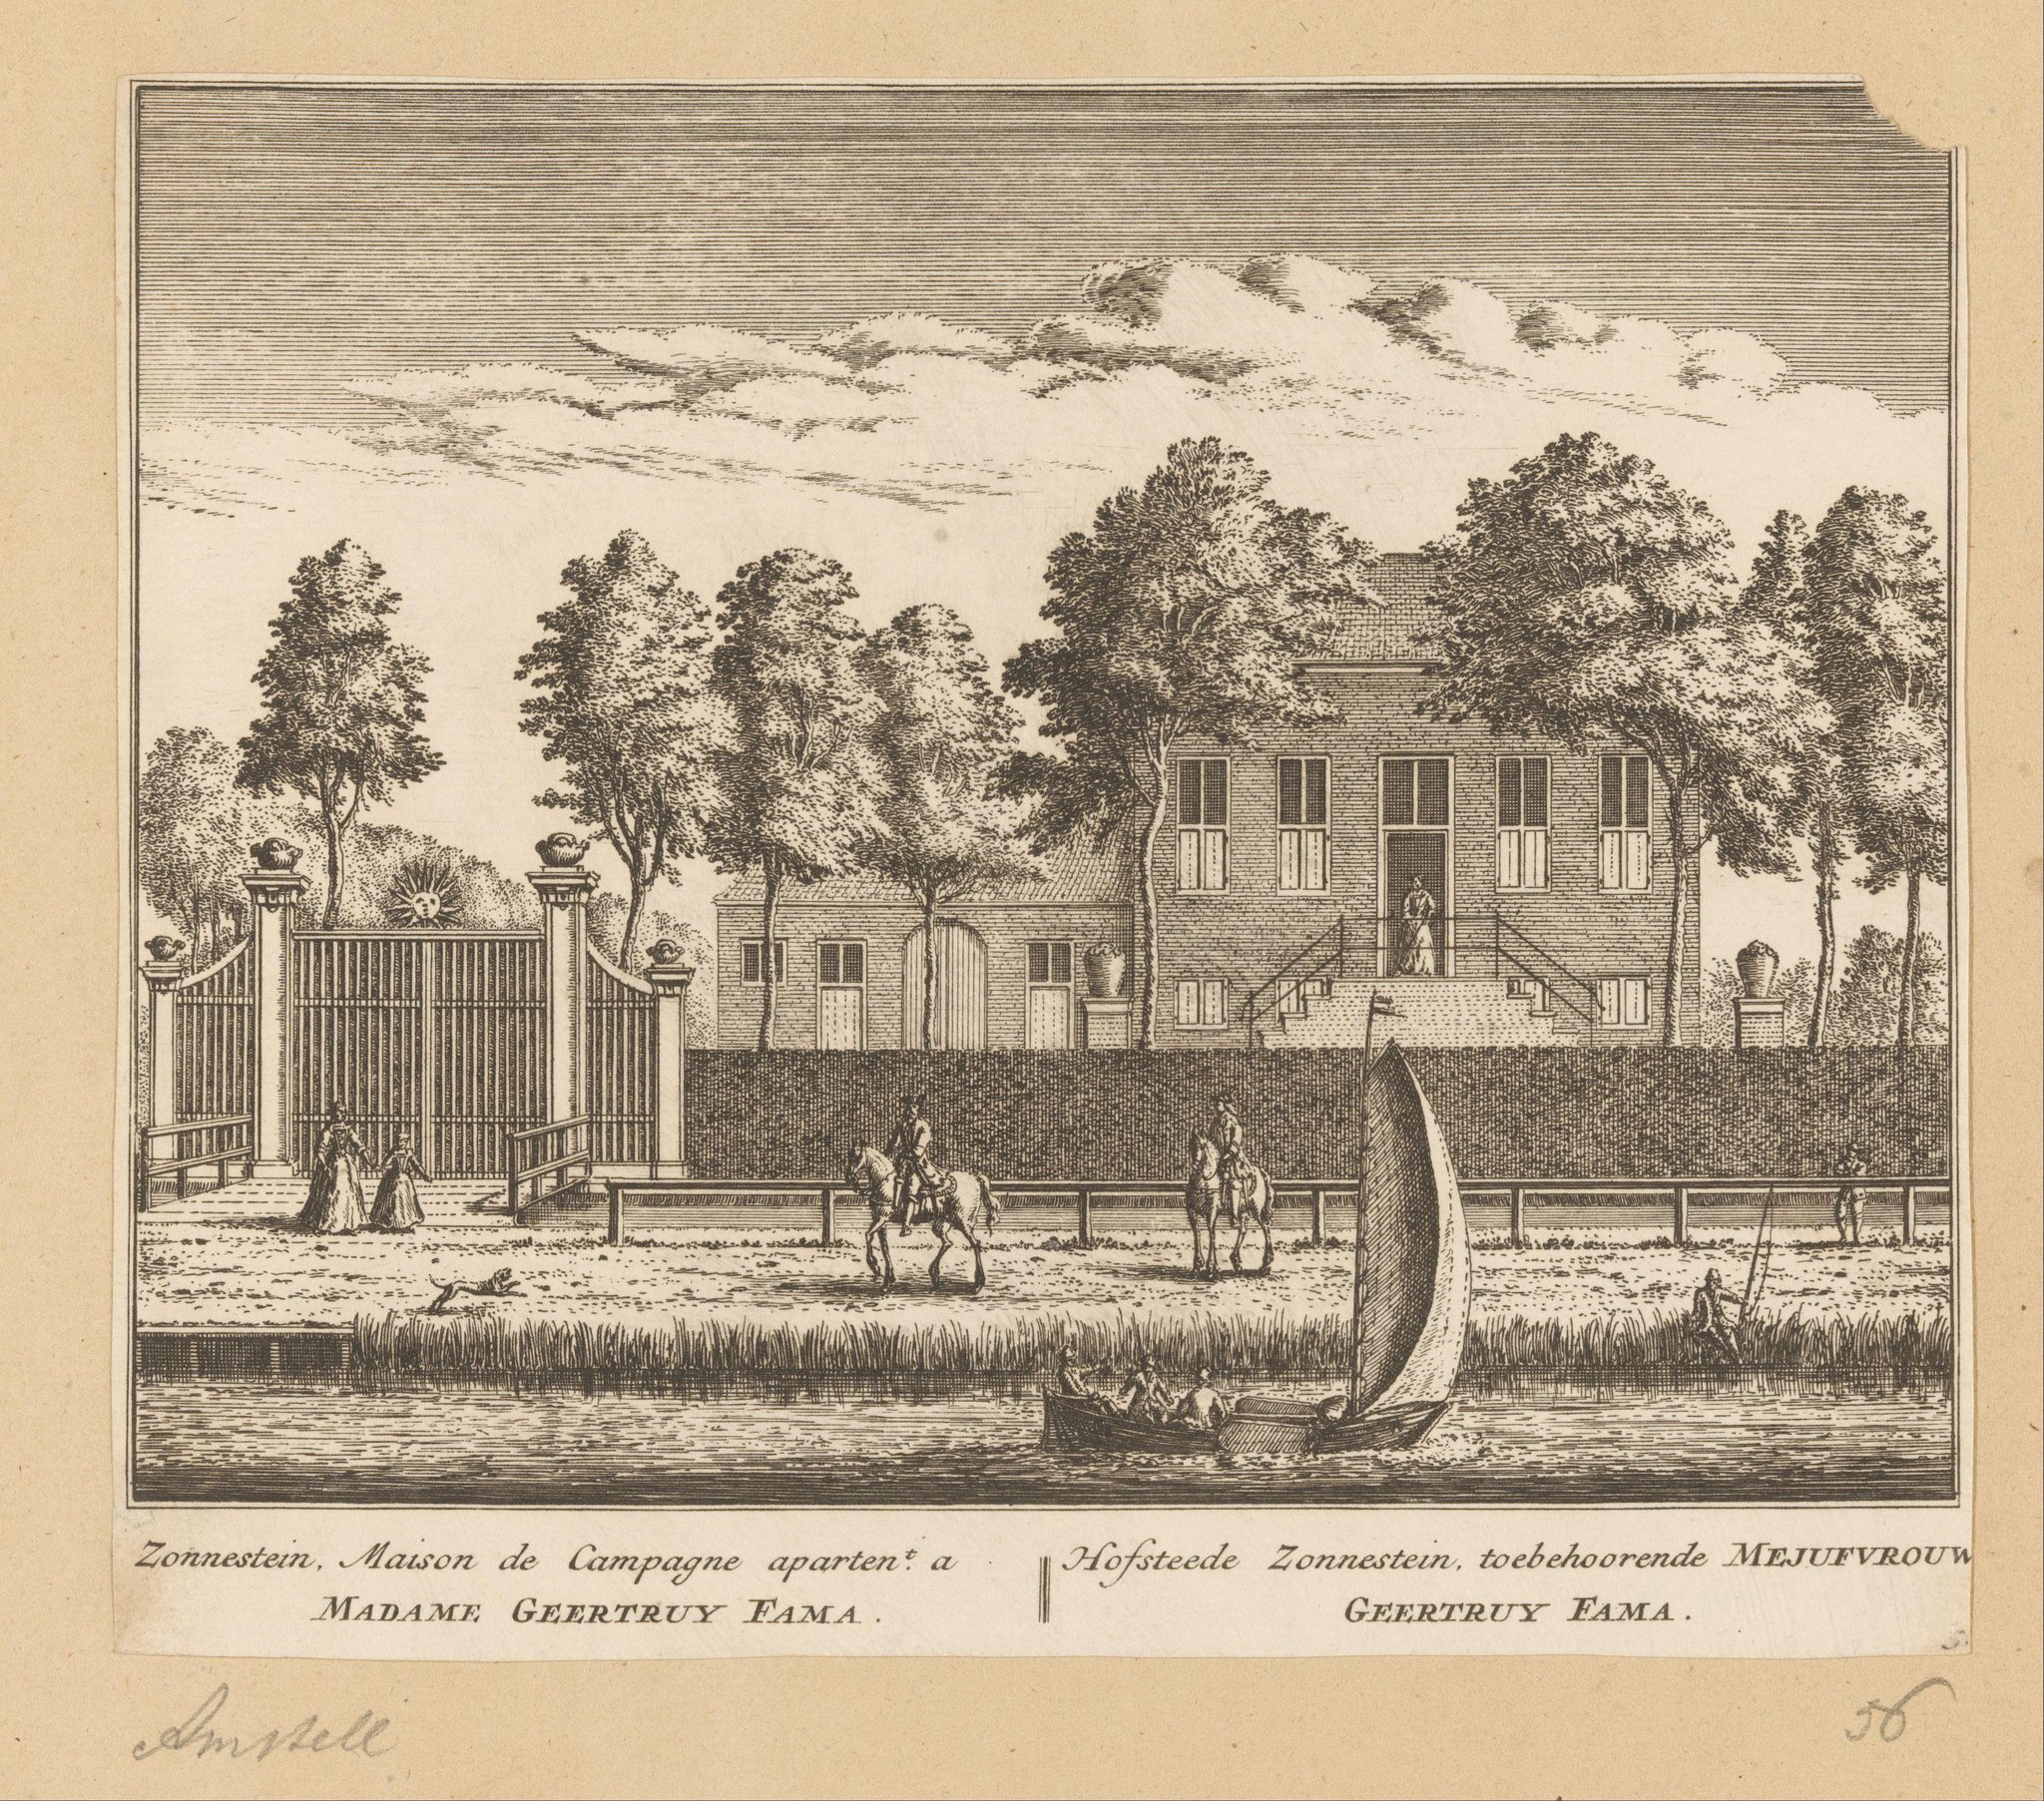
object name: book illustration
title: Gezicht op Hofstede Zonnestein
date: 1730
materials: paper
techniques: etching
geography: amsterdam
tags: civic architecture; edifices; dwellings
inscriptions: inscription: ‘52’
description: Prent uit: Tijsens, Gijsbert. Hollands Arcadia, of de vermaarde rivier den Amstel (...) naar 't léven getekend en in 't ligt gebgragt door Abraham Rademaker (...). Amsterdam: Leonardus Schenk, 1730.